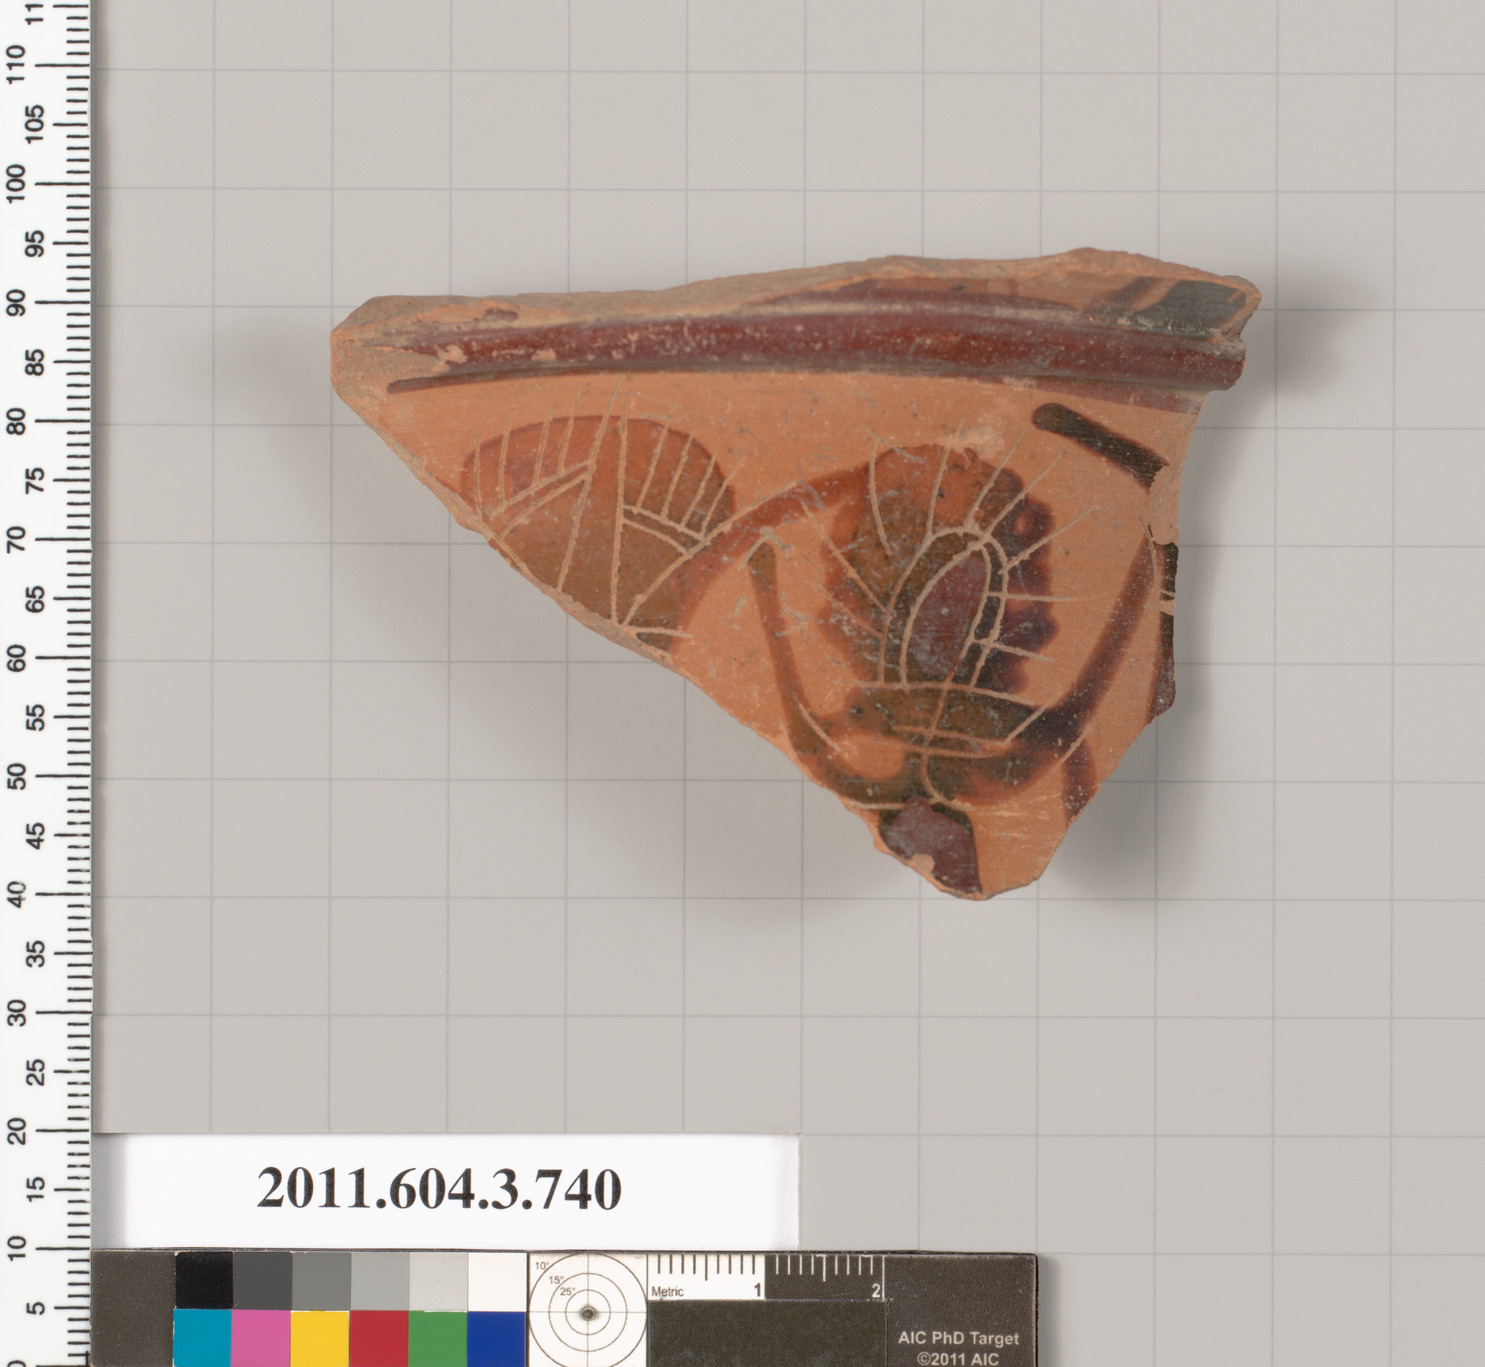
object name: neck amphora, tyrrhenian fragment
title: Terracotta fragment of a neck-amphora (jar)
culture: greek, attic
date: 575-551 BCE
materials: terracotta